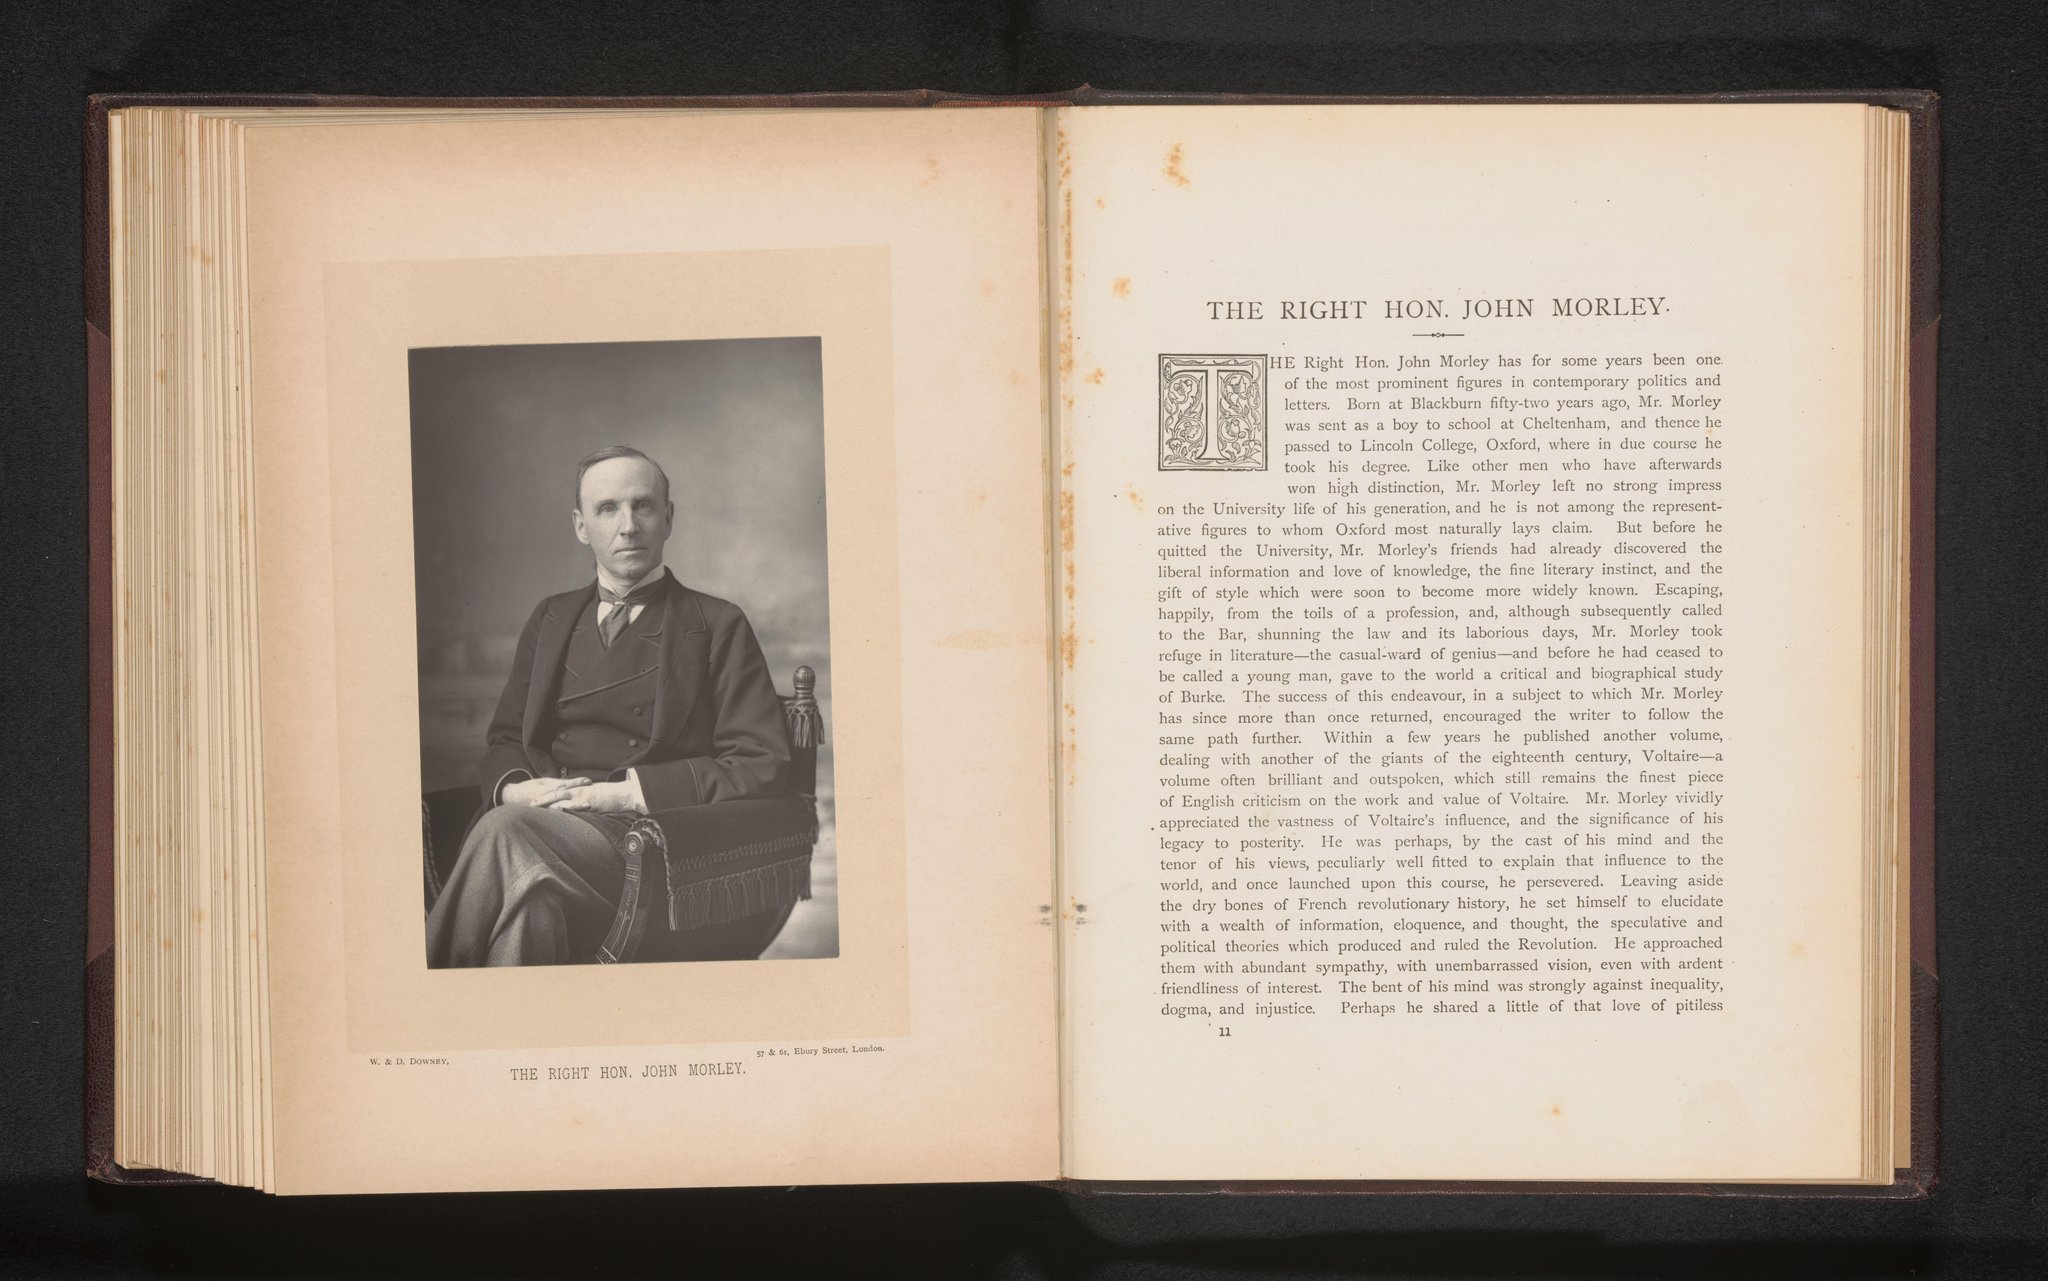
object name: photograph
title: The Right Hon. John Morley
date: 1885-1890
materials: paper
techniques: carbon print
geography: london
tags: historical persons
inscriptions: address: ‘57 & 61, Ebury Street, London.’